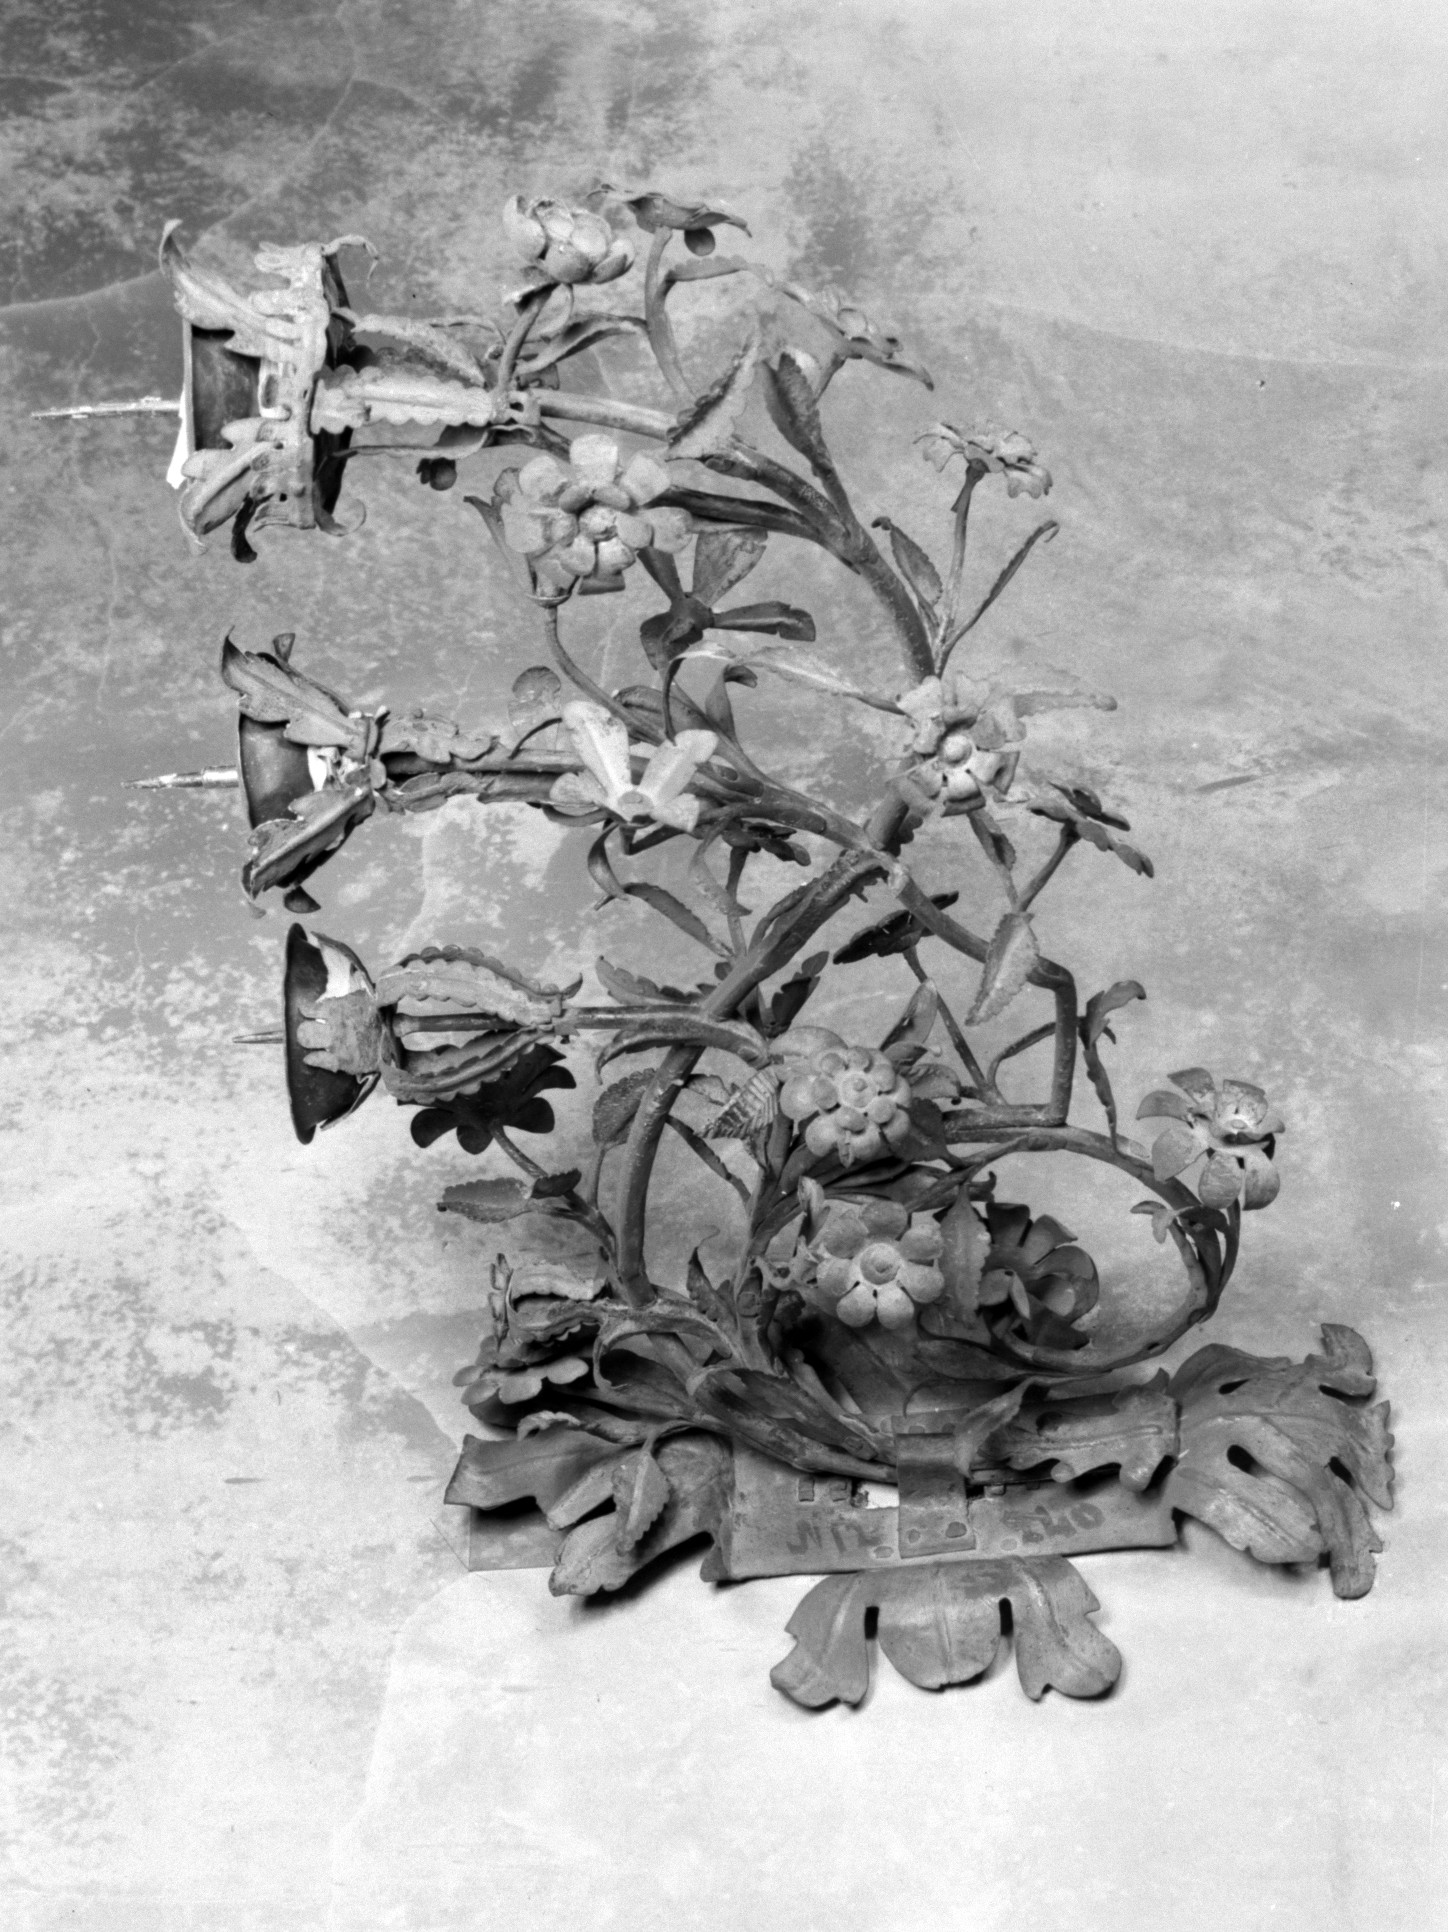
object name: wall sconce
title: Pair of wall sconces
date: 1601-1800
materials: iron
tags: flowers